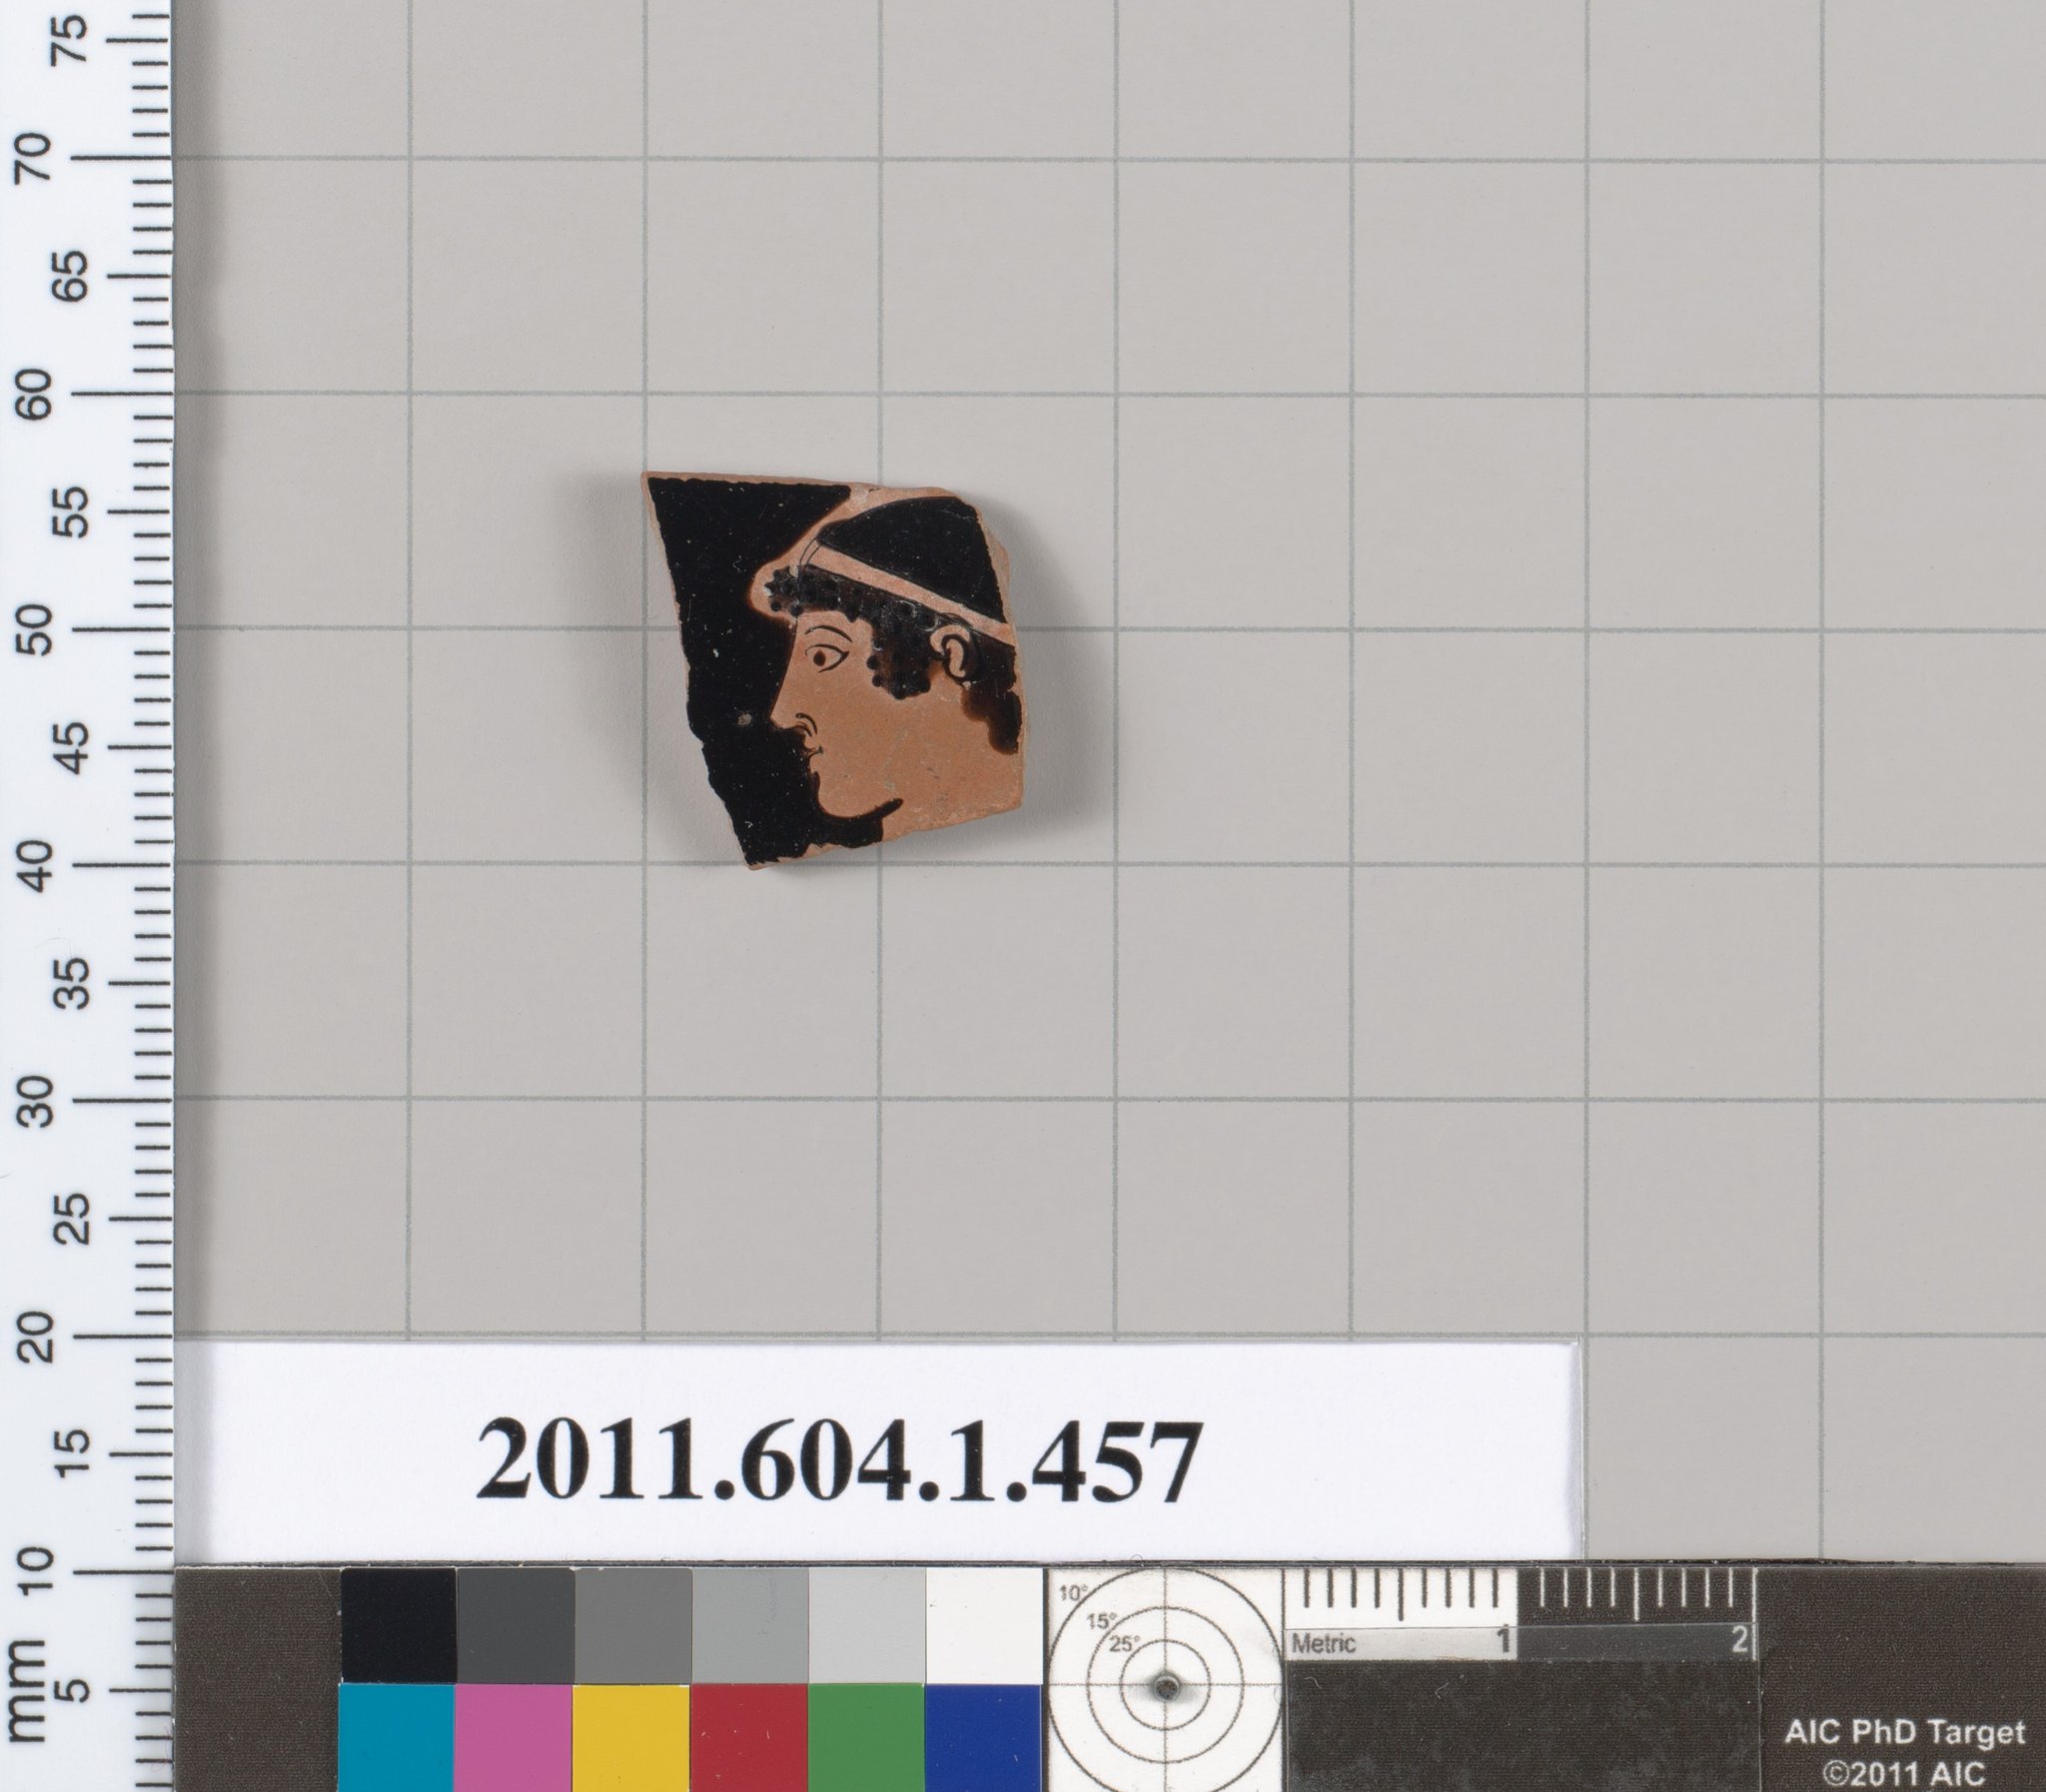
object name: kylix fragment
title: Terracotta fragment of a kylix (drinking cup)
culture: greek, attic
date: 401-450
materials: terracotta